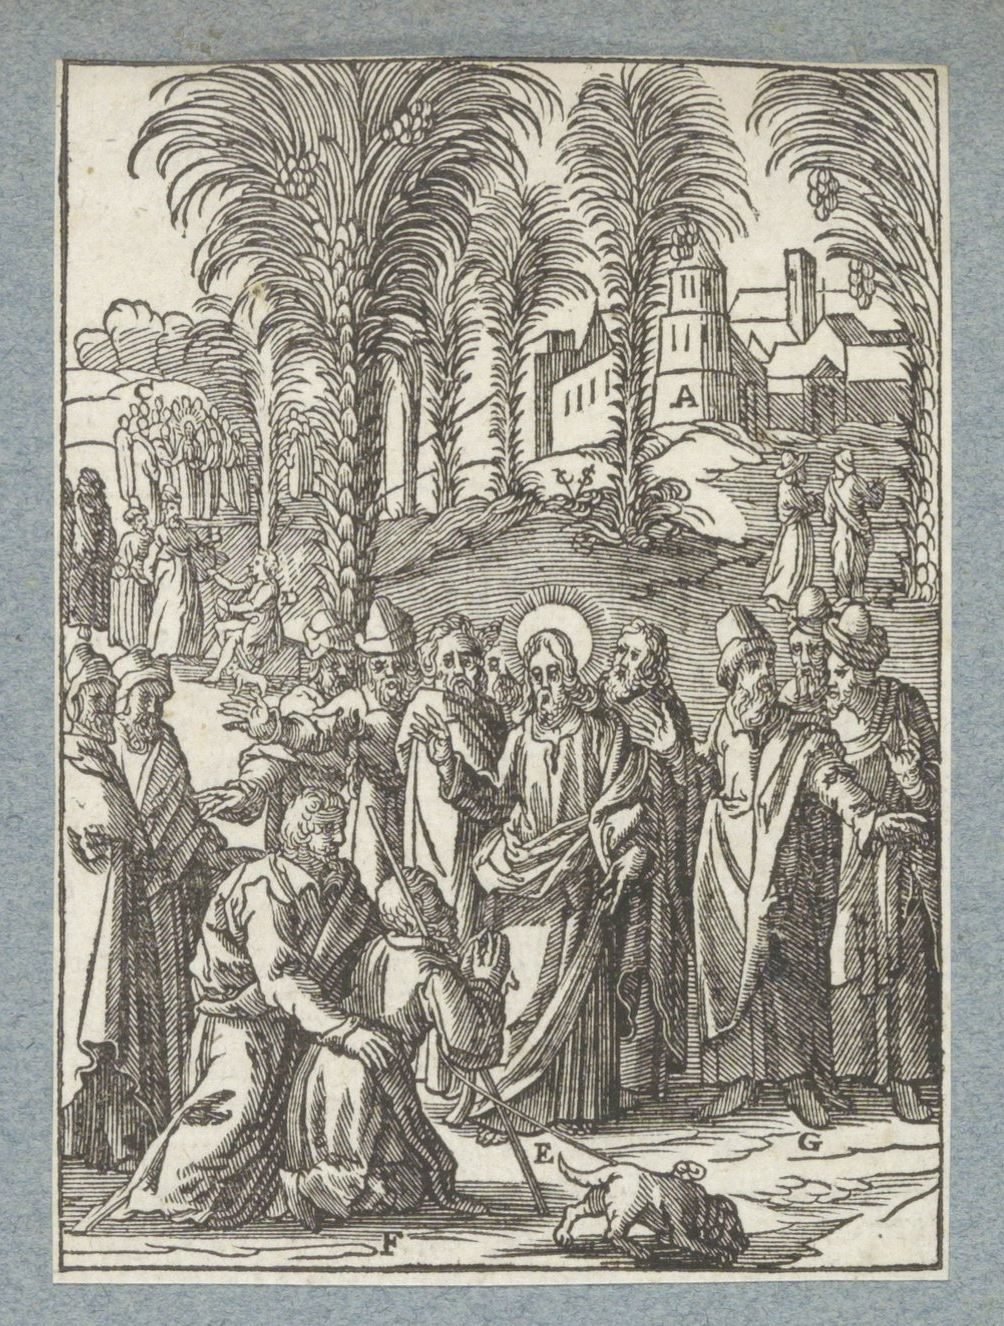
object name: print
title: Genezing van de blinde van Jericho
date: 1629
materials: paper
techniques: letterpress printing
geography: amsterdam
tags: healing of two blind men, or one (bartimaeus), sitting near jericho (matthew 20:29-34; mark 10:46-52; luke 18:35-43)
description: De prent is afkomstig uit een van de uitgaven van P.J. Paets uit Amsterdam. Ze wordt voor het eerst gebruikt in: Der Zielen Lust-hof. Leuven, I.Jacbosz voor P.J. Paets [= Amsterdam, P.J. Paets], 1629. De voorstelling is gekopieerd naar een prent van Antonie II Wierix voor: Nadal, Jerónimo. Evangelicae Historiae Imagines. Antwerpen, M. Nutius, 1593.